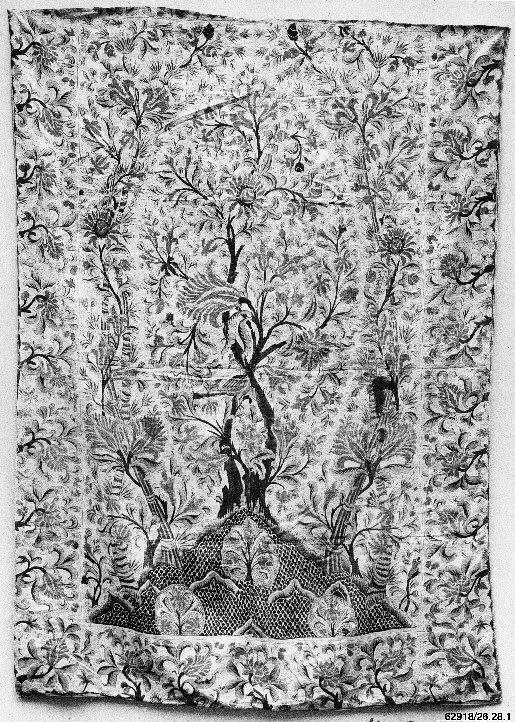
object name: hanging or bed cover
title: Hanging or Bed Cover (Palampore)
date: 1701-1733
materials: cotton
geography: india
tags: flowers